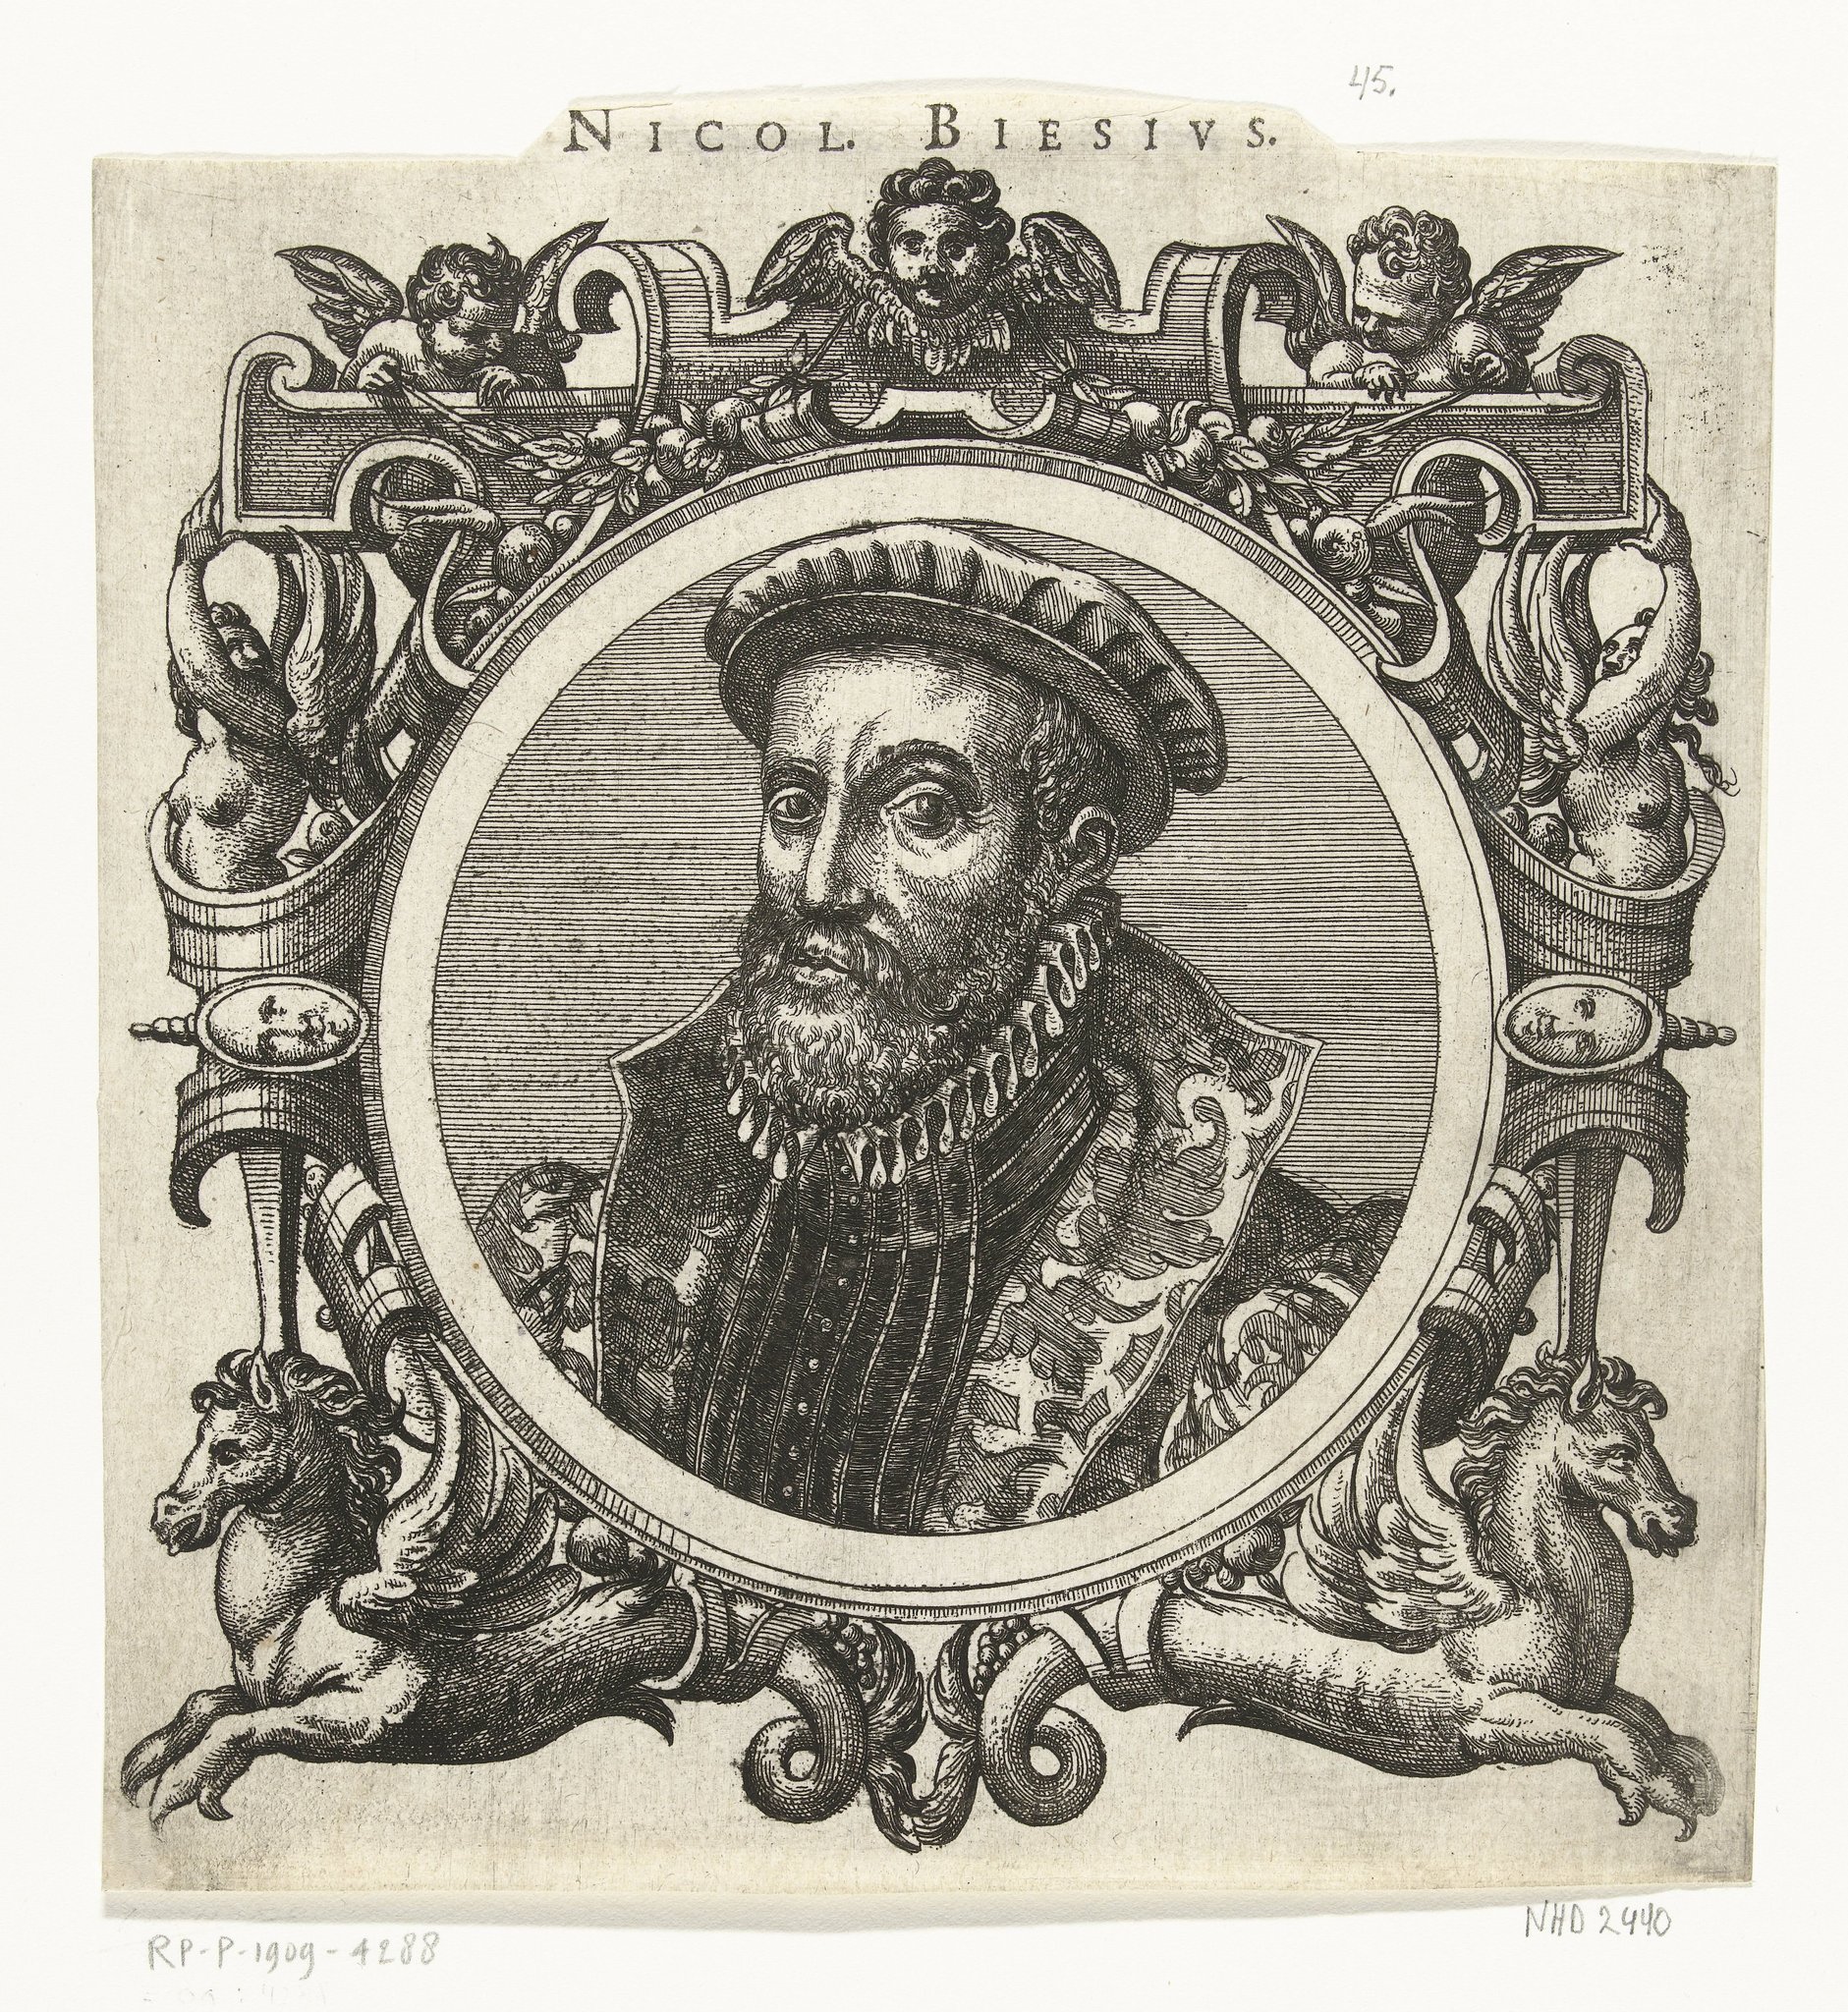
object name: print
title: Portret van Nicolaus Biesius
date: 1574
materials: paper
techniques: etching, letterpress printing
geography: vienna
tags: ghent, ornament ~ cartouche, fabulous animals ~ hoofed animals: winged horse, seraphim, cherubim, cupids: 'amores', 'amoretti', 'putti'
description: Een portret met een ronde lijst van Nicolaus Biesius, de persoonlijke lijfarts van keizer Maximiliaan II. Buste naar links. De cartouche van het portret toont twee putti, twee engelen en twee pegasi. Boven de cartouche de naam van de geportretteerde persoon.